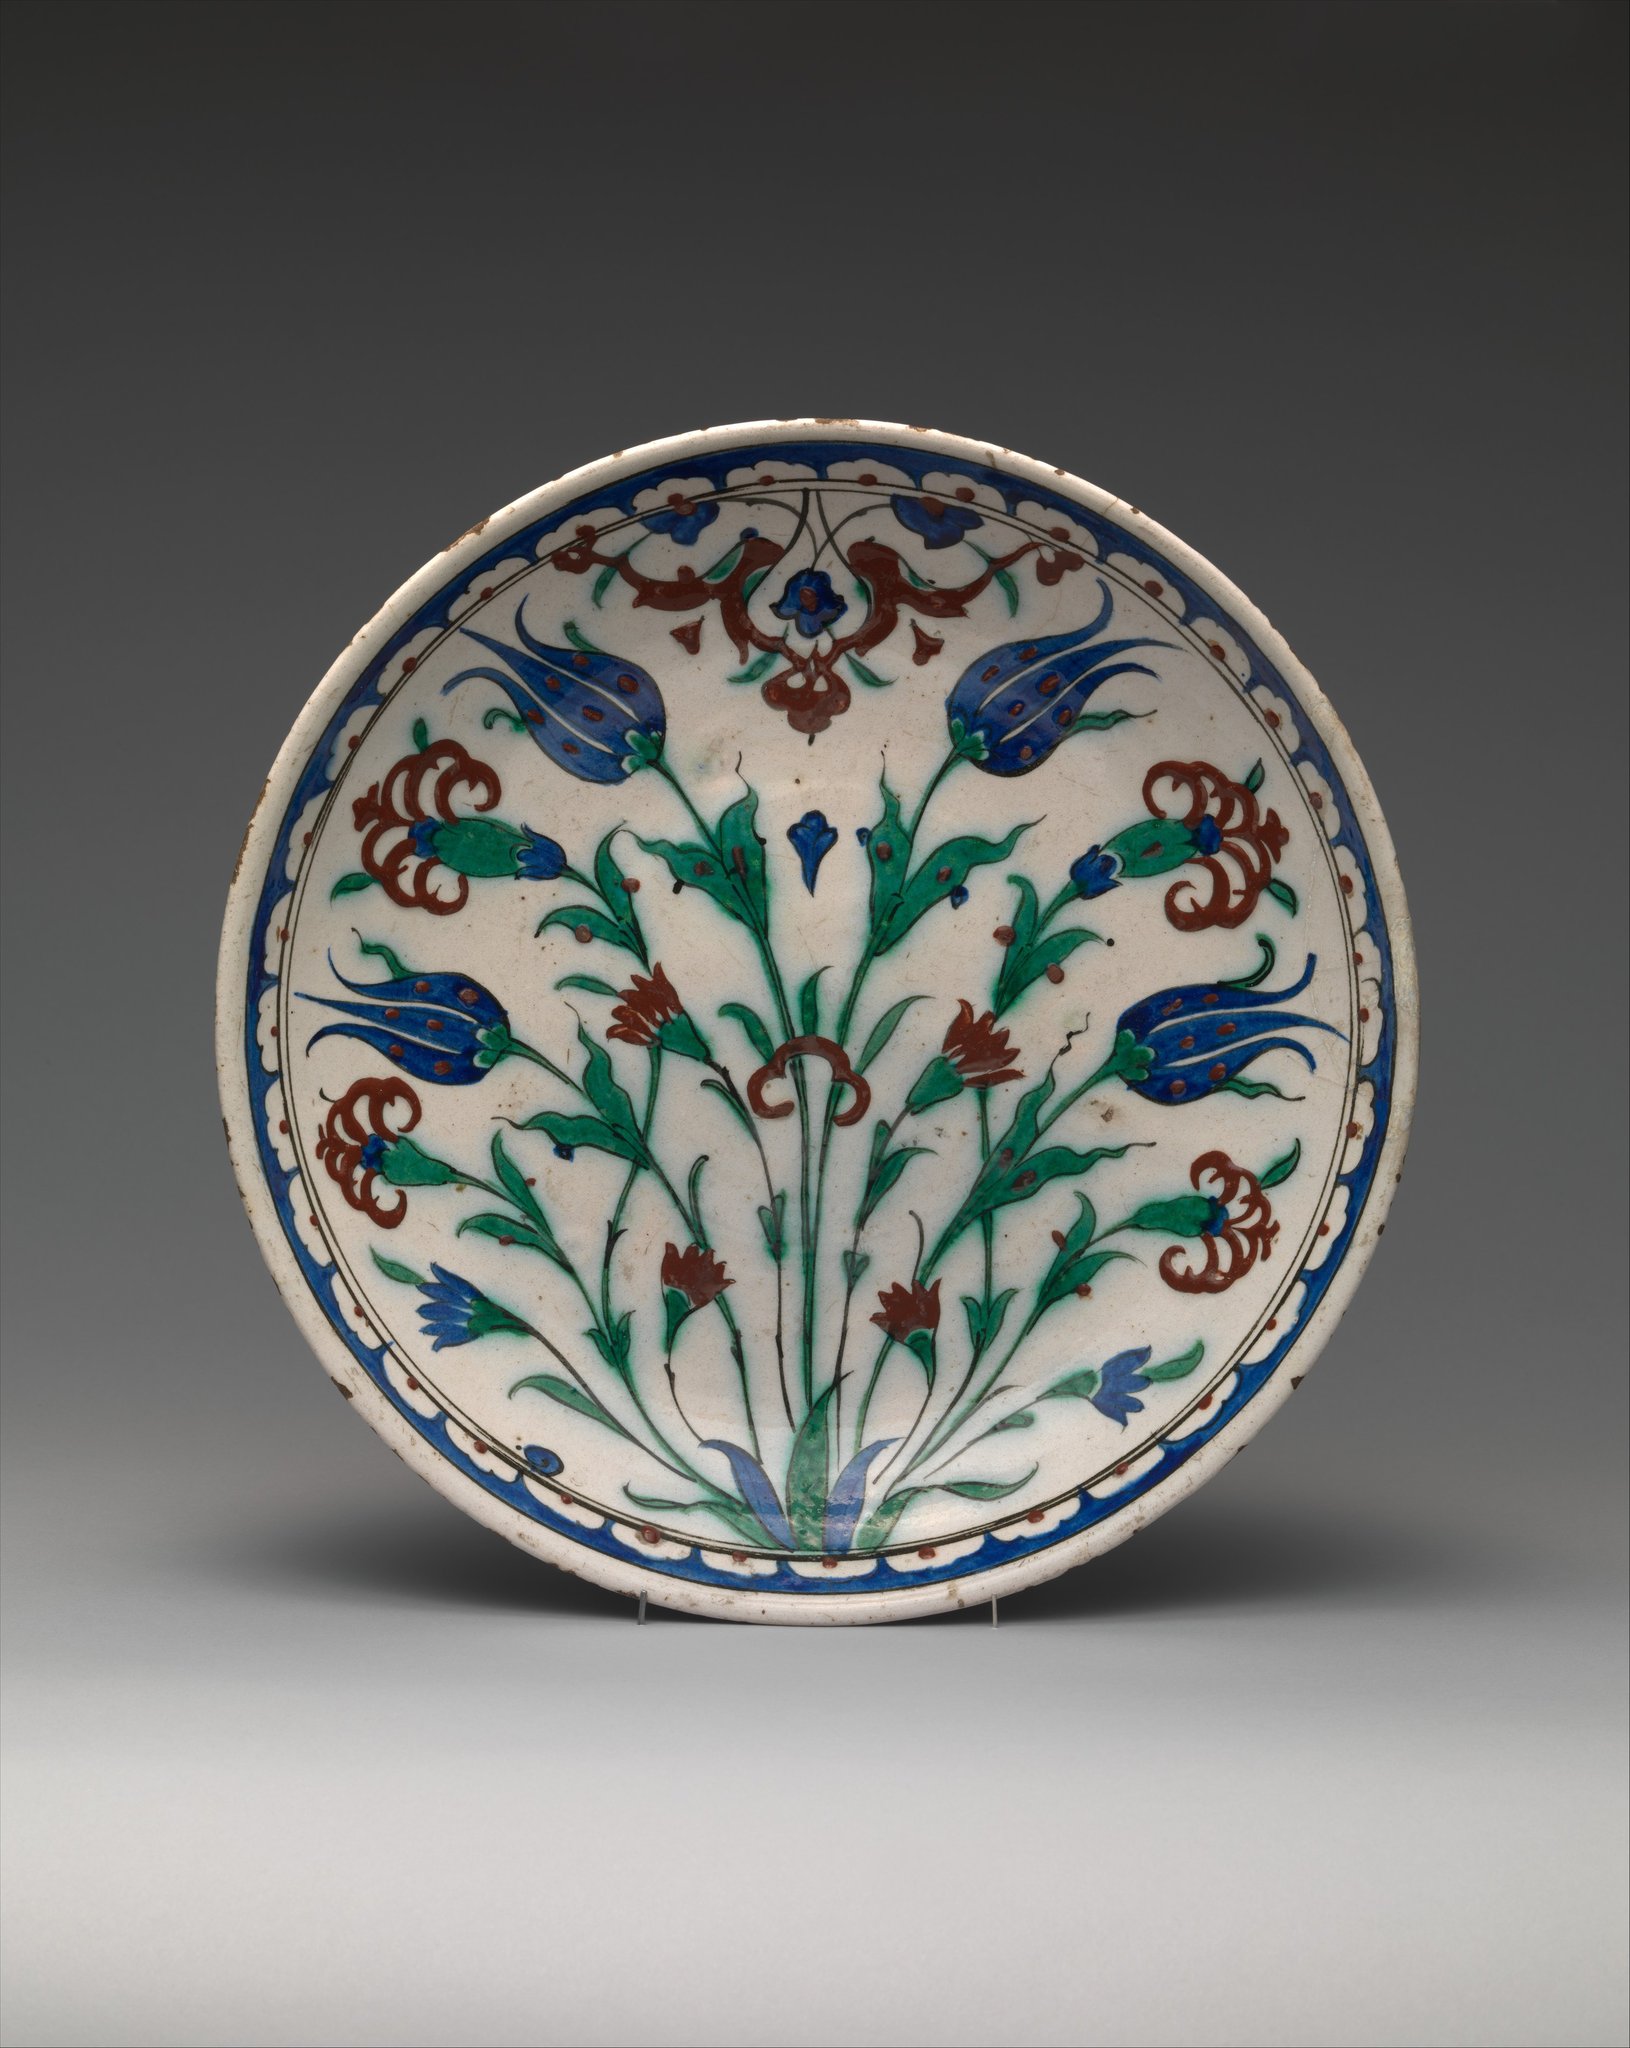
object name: dish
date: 1567-1600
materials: stonepaste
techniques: glazing, painting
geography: turkey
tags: flowers